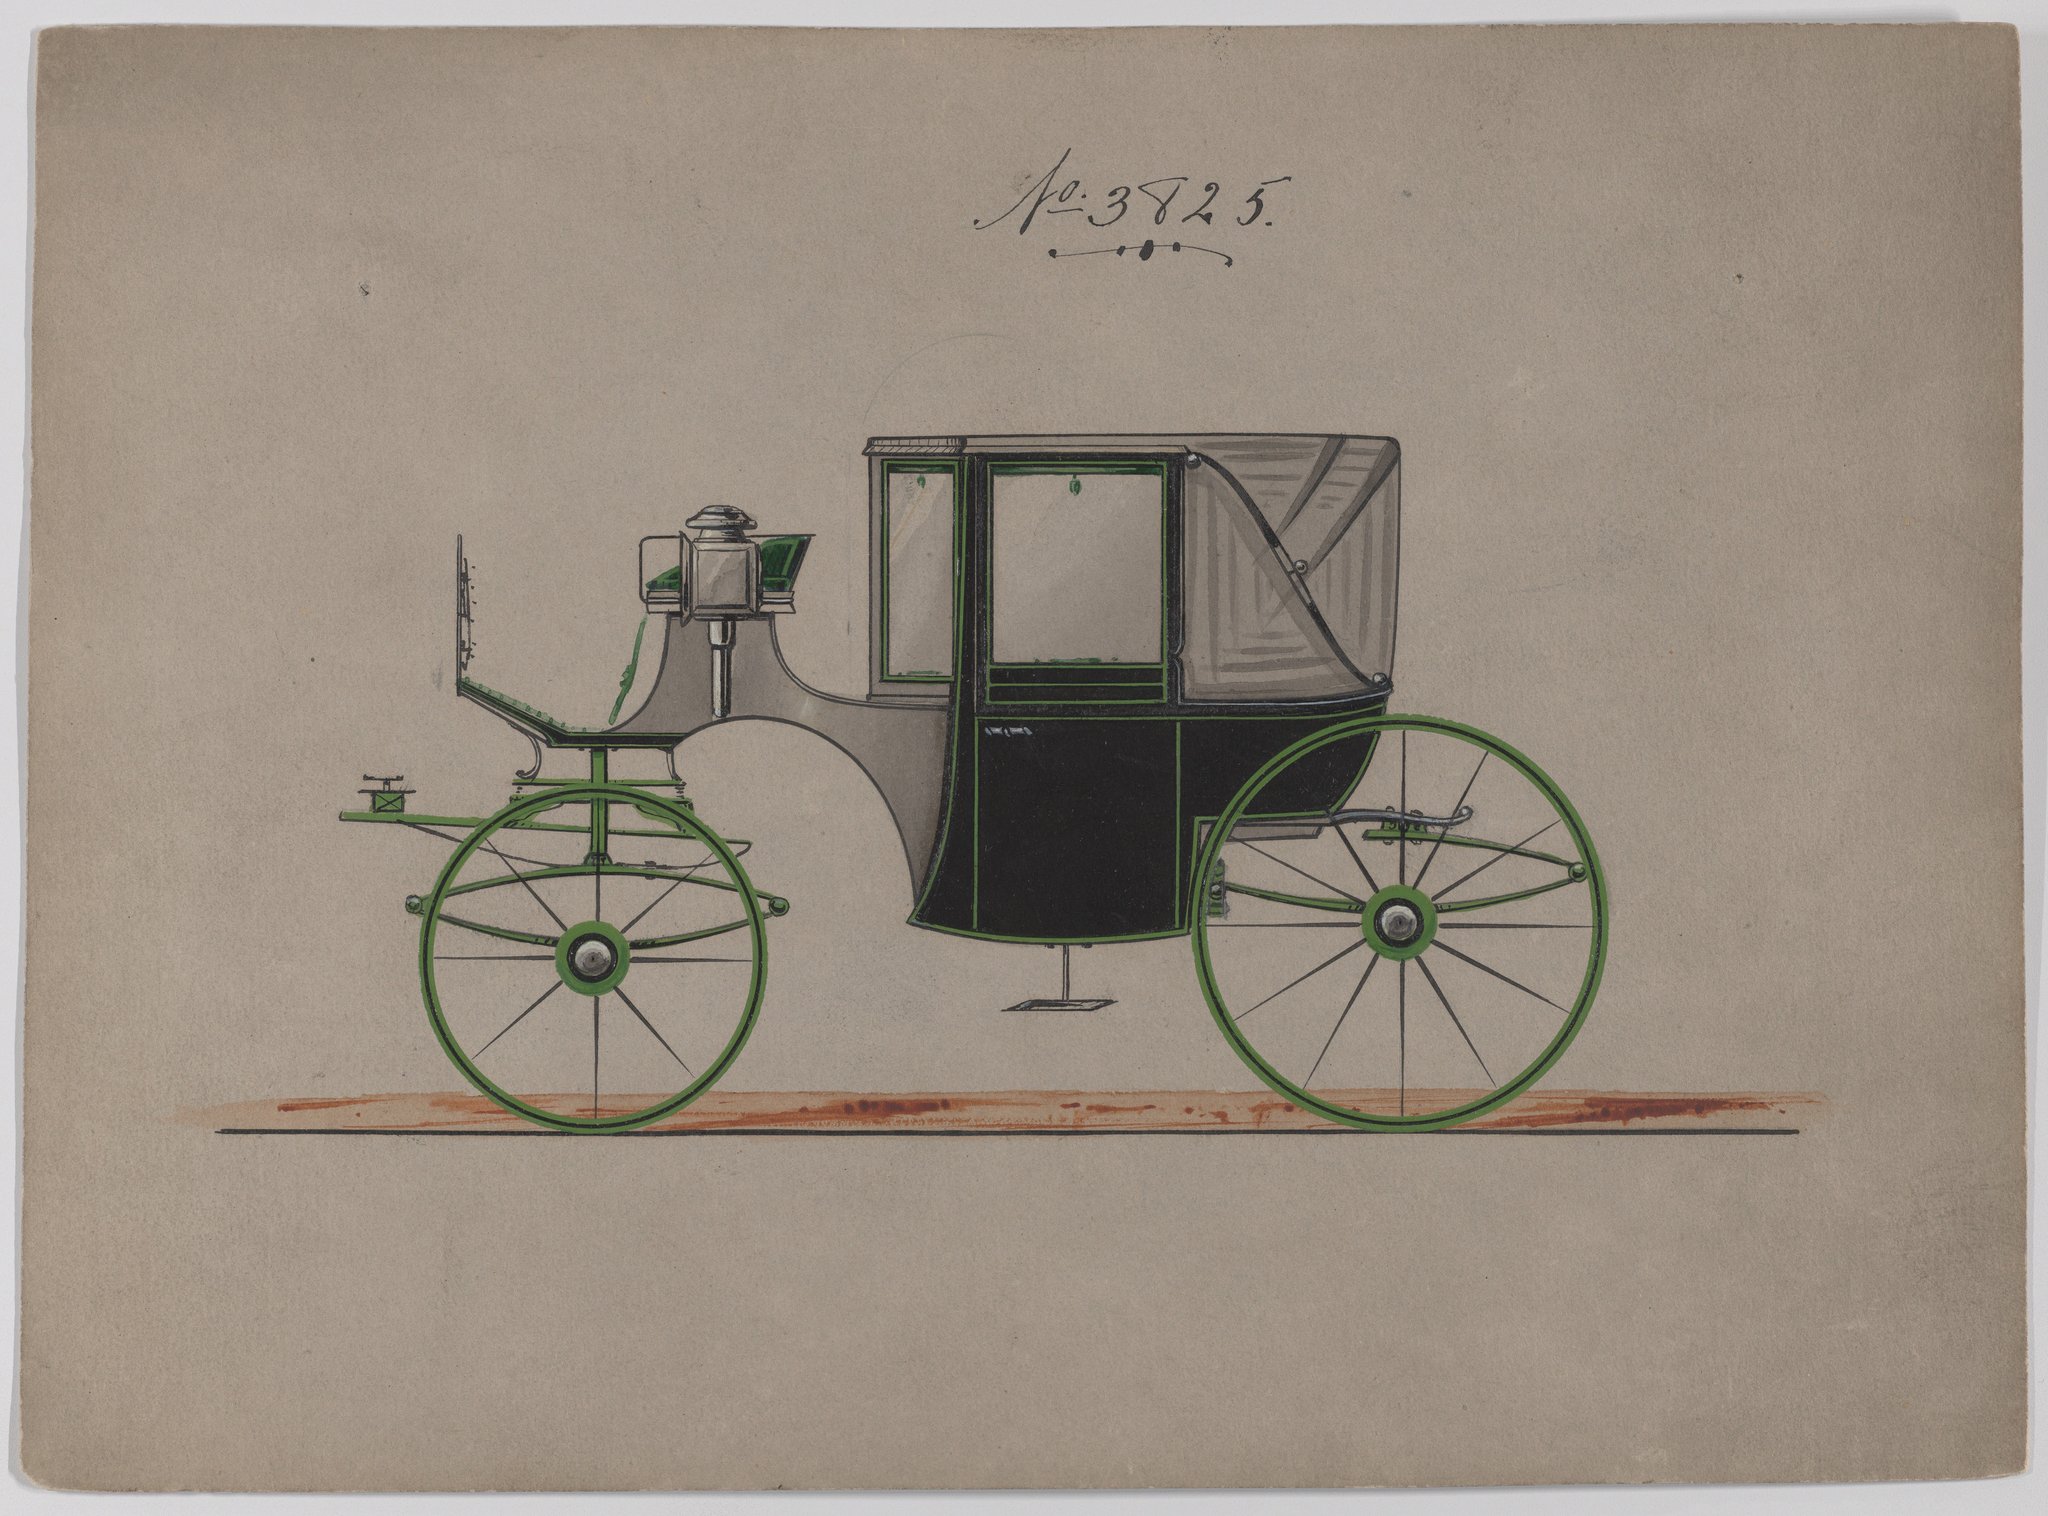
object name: drawing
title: Design for Landaulet, no. 3825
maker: brewster & co.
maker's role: manufacturer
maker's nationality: american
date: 1883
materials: gouache, gum arabic, ink, watercolor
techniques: pen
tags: carriages